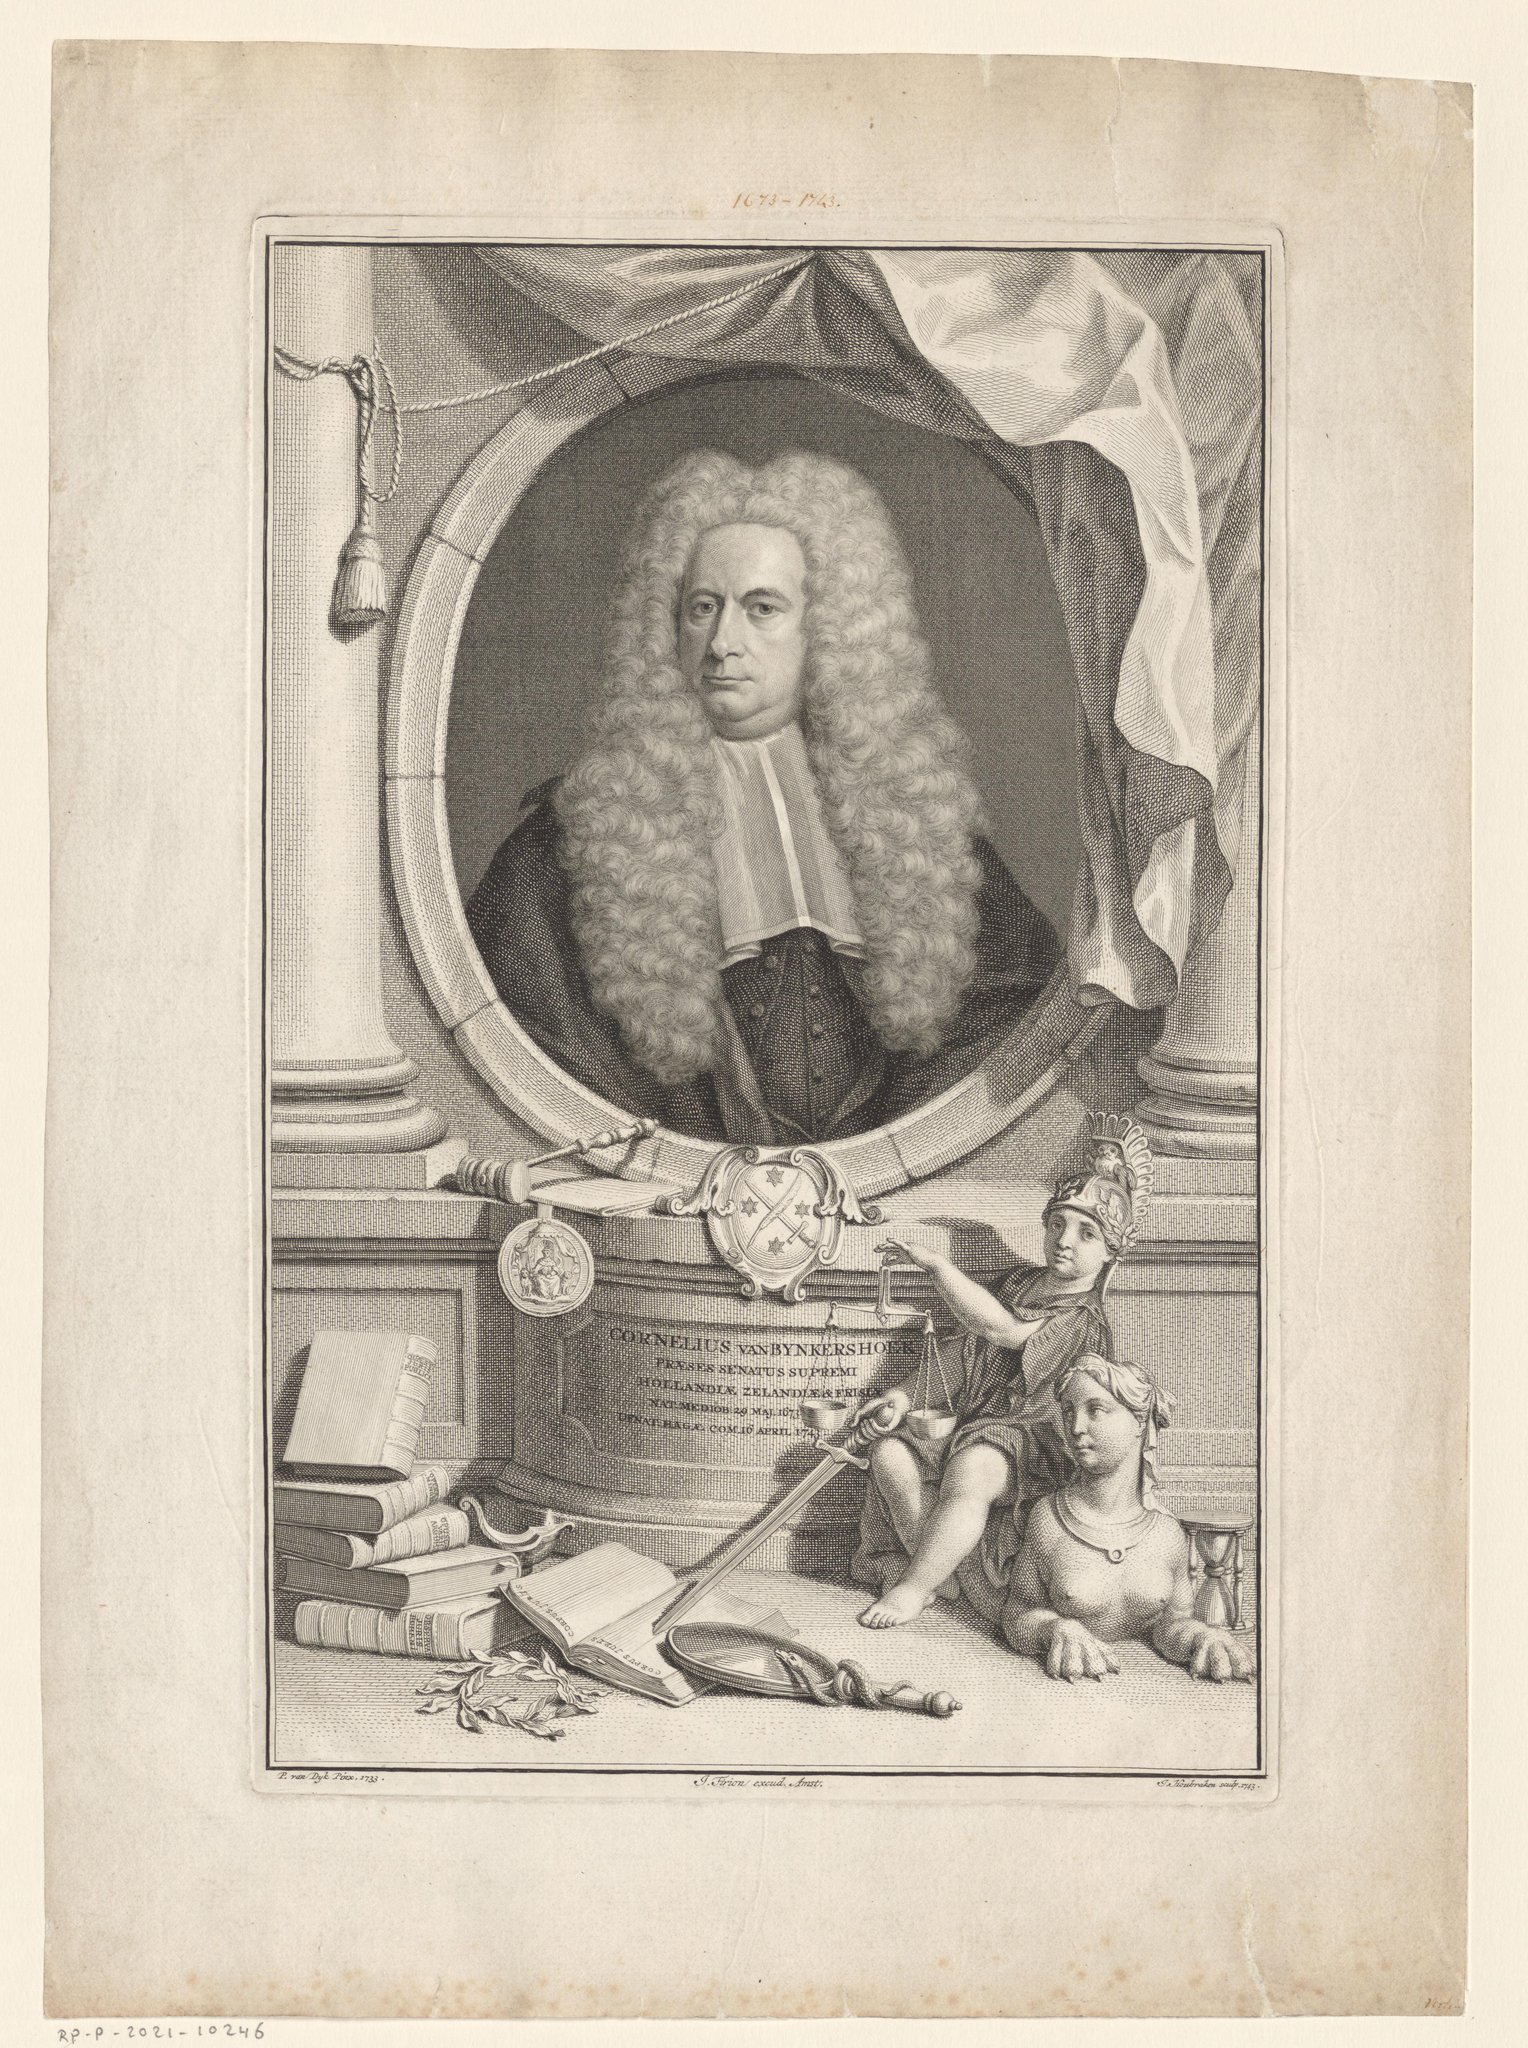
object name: print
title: Portret van Cornelis van Bynkershoek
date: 1743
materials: paper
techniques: engraving, etching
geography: amsterdam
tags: sphinx (lion/woman); 'sfinge' (ripa), historical persons, book, armorial bearing, heraldry, symbols and allegories of jurisprudence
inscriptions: collector's mark: Lugt 2228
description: Met onder het portret zijn wapenschild. Op de voorgrond de personificatie van de rechtspraak, gezeten op de rug van een sfinx. Links op de voorgrond boeken over de rechtspraak, een lauwerkrans en een spiegel met een slang rond het handvat.